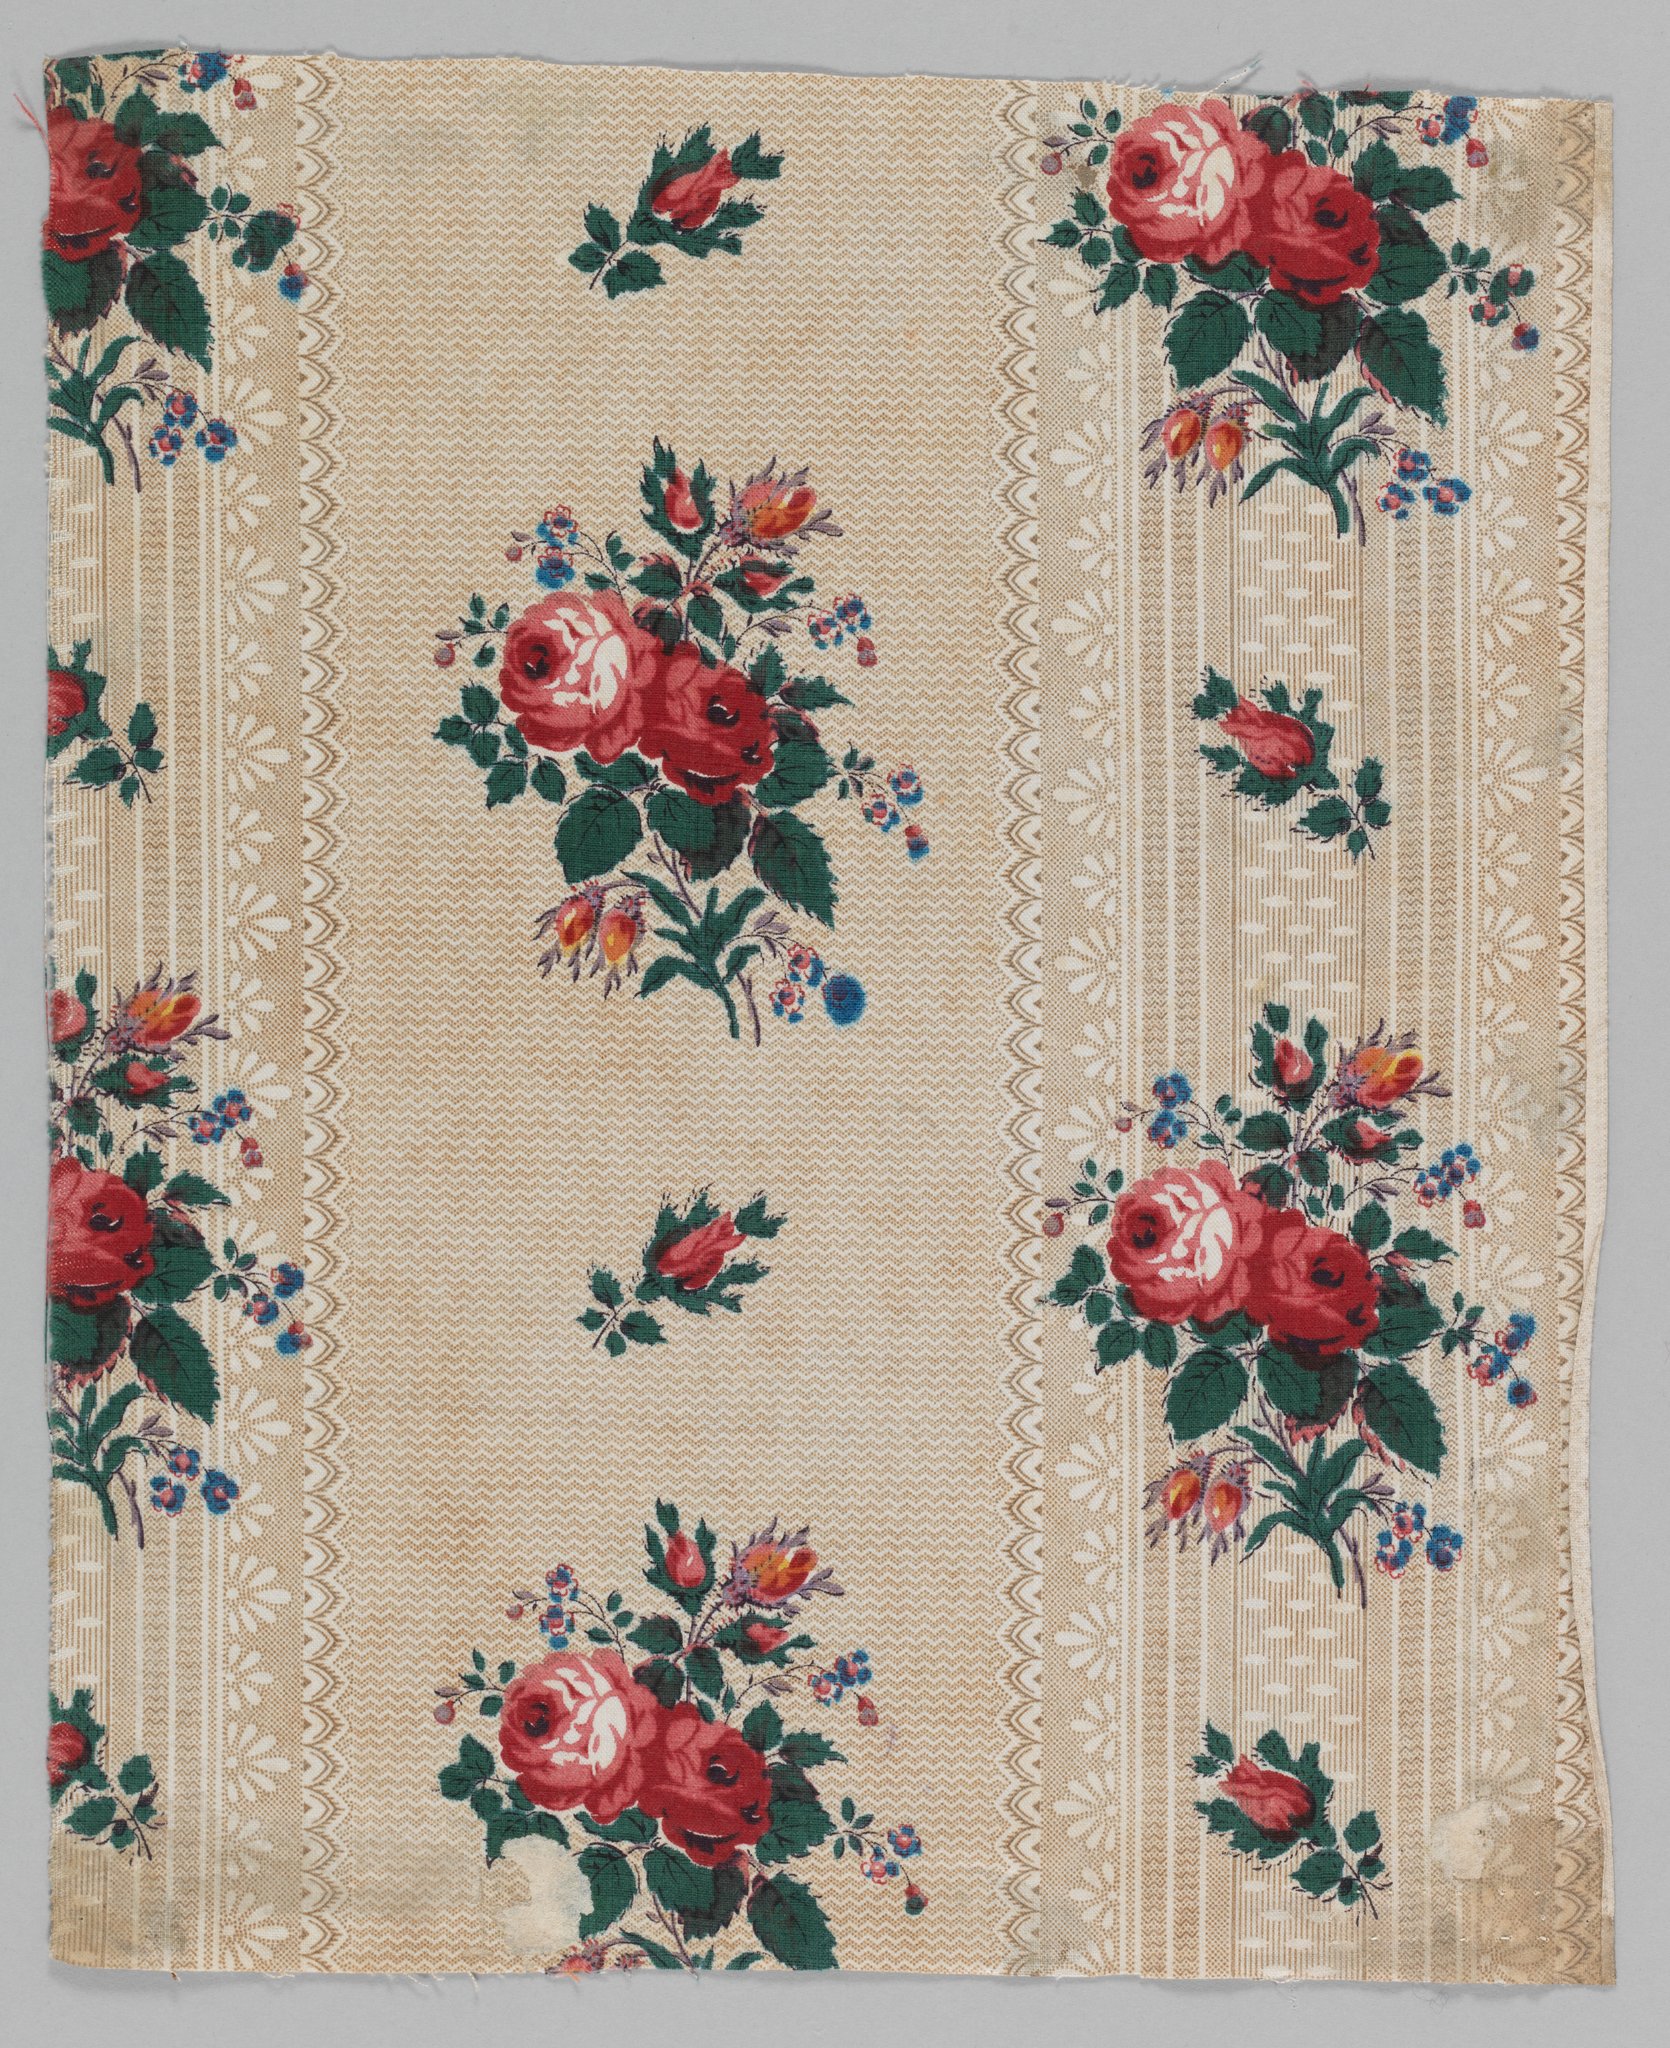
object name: piece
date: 1801-1900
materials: cotton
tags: roses